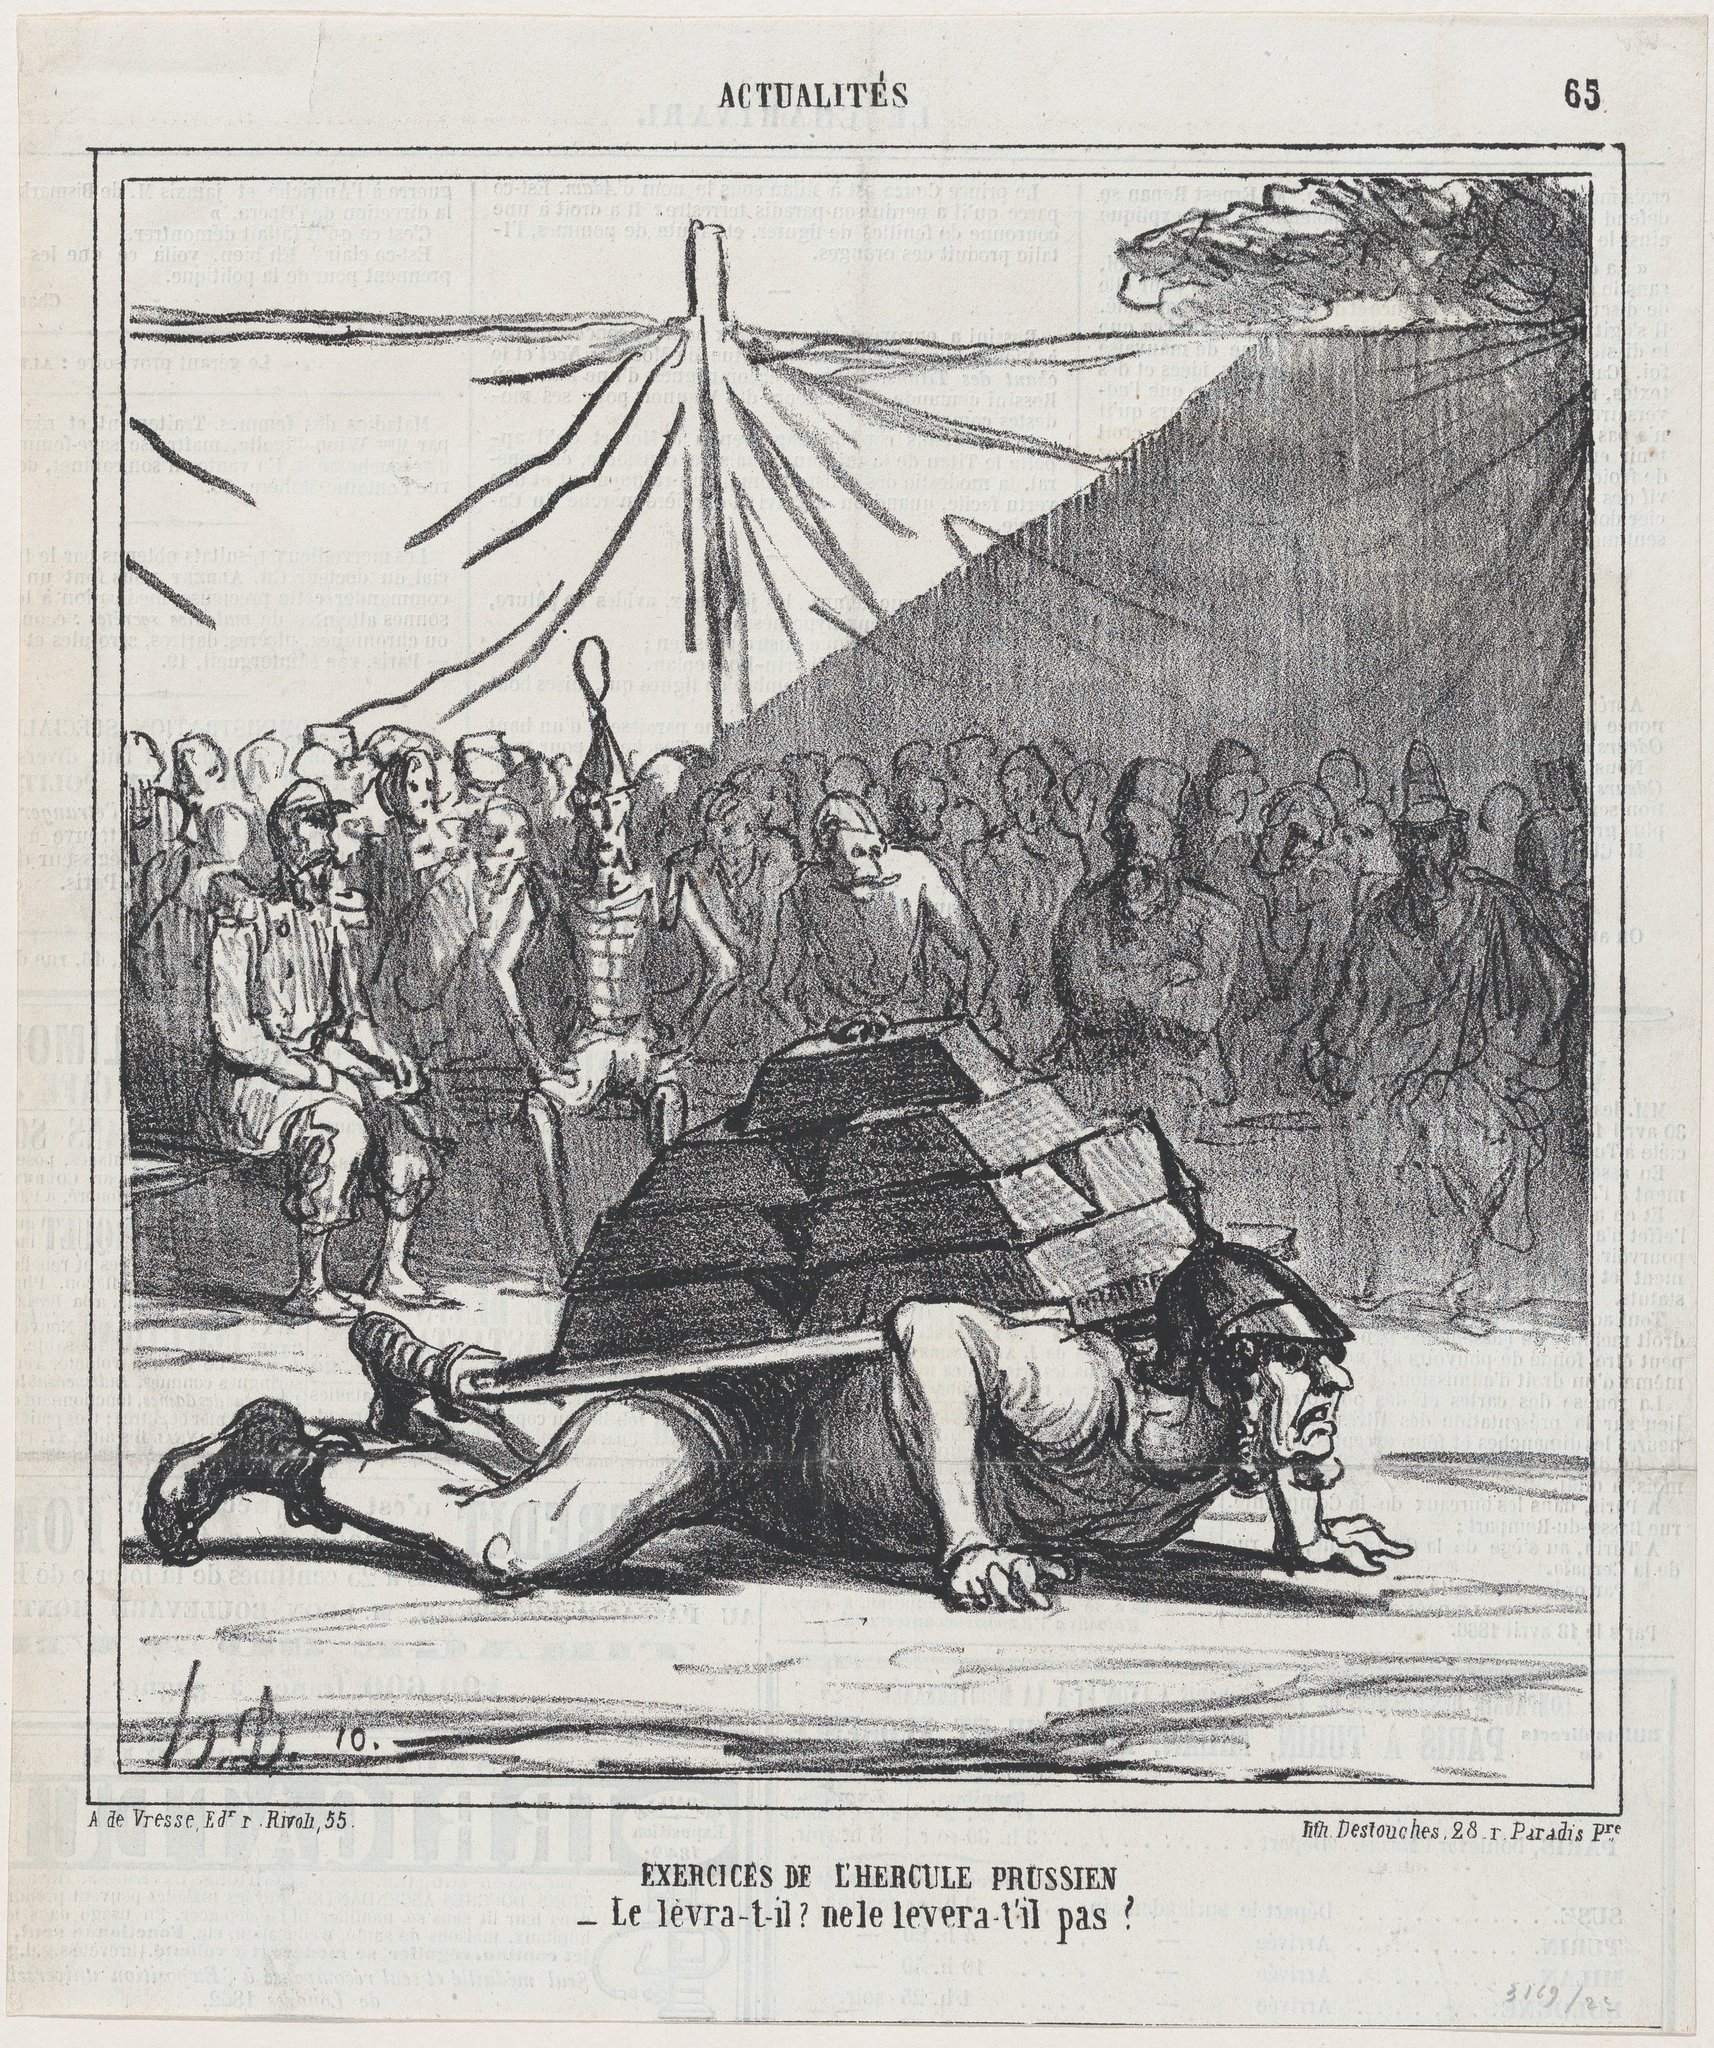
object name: print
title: Exercises of the Prussian Hercules: Will he or won't he be able to lift it up?, from 'News of the day,' published in "Le Charivari"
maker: honoré daumier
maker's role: artist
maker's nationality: french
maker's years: 1808-1879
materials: paper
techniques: lithograph